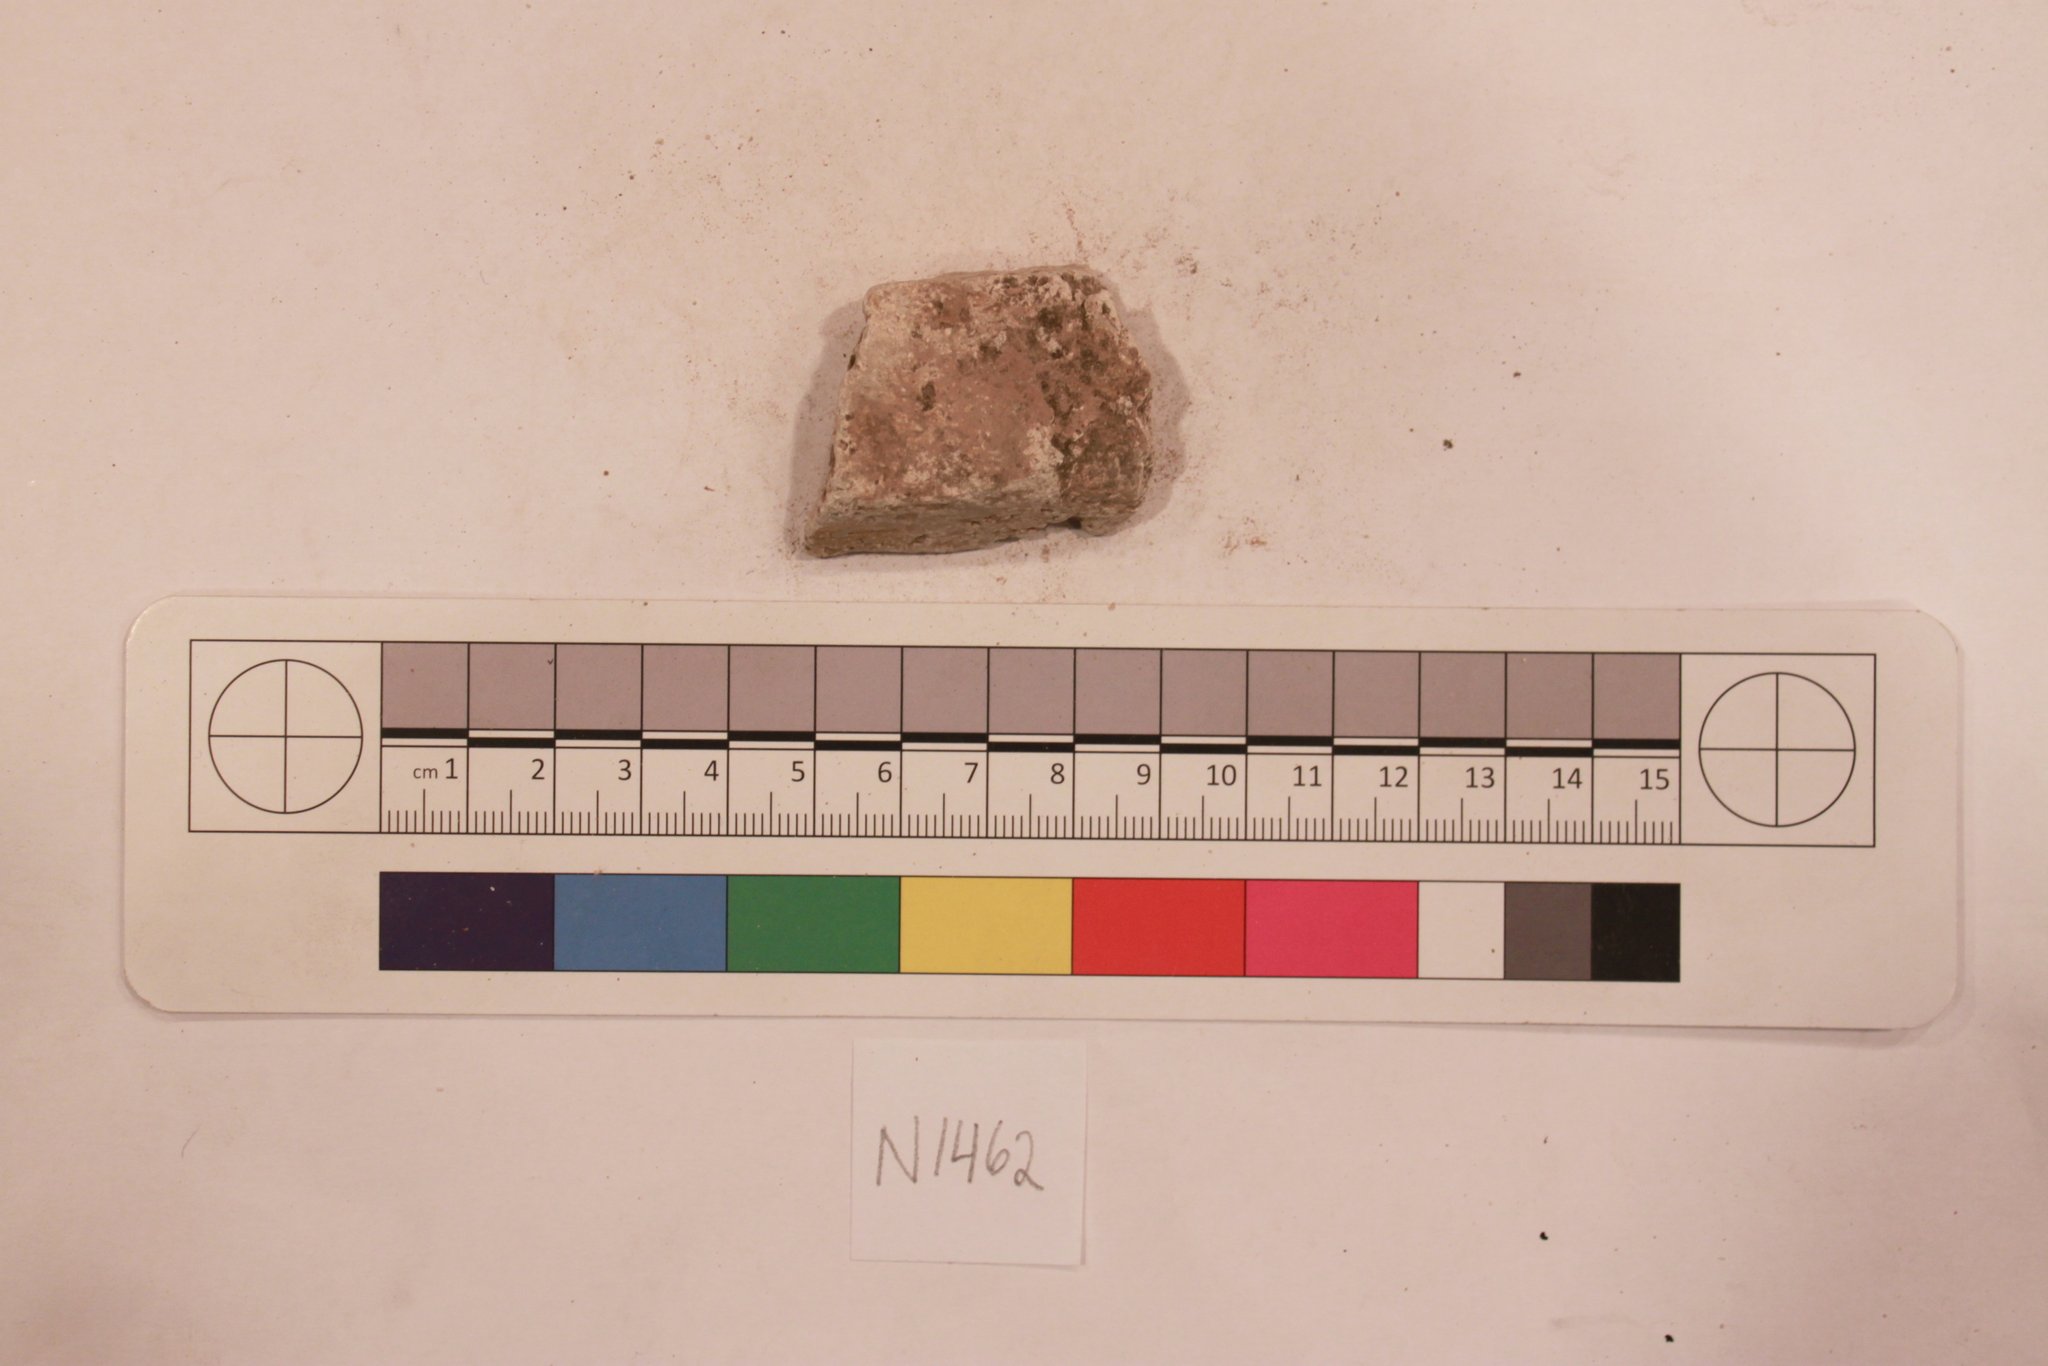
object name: fragment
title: Stucco Fragment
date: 701-1200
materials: plaster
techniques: carving, painting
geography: iran